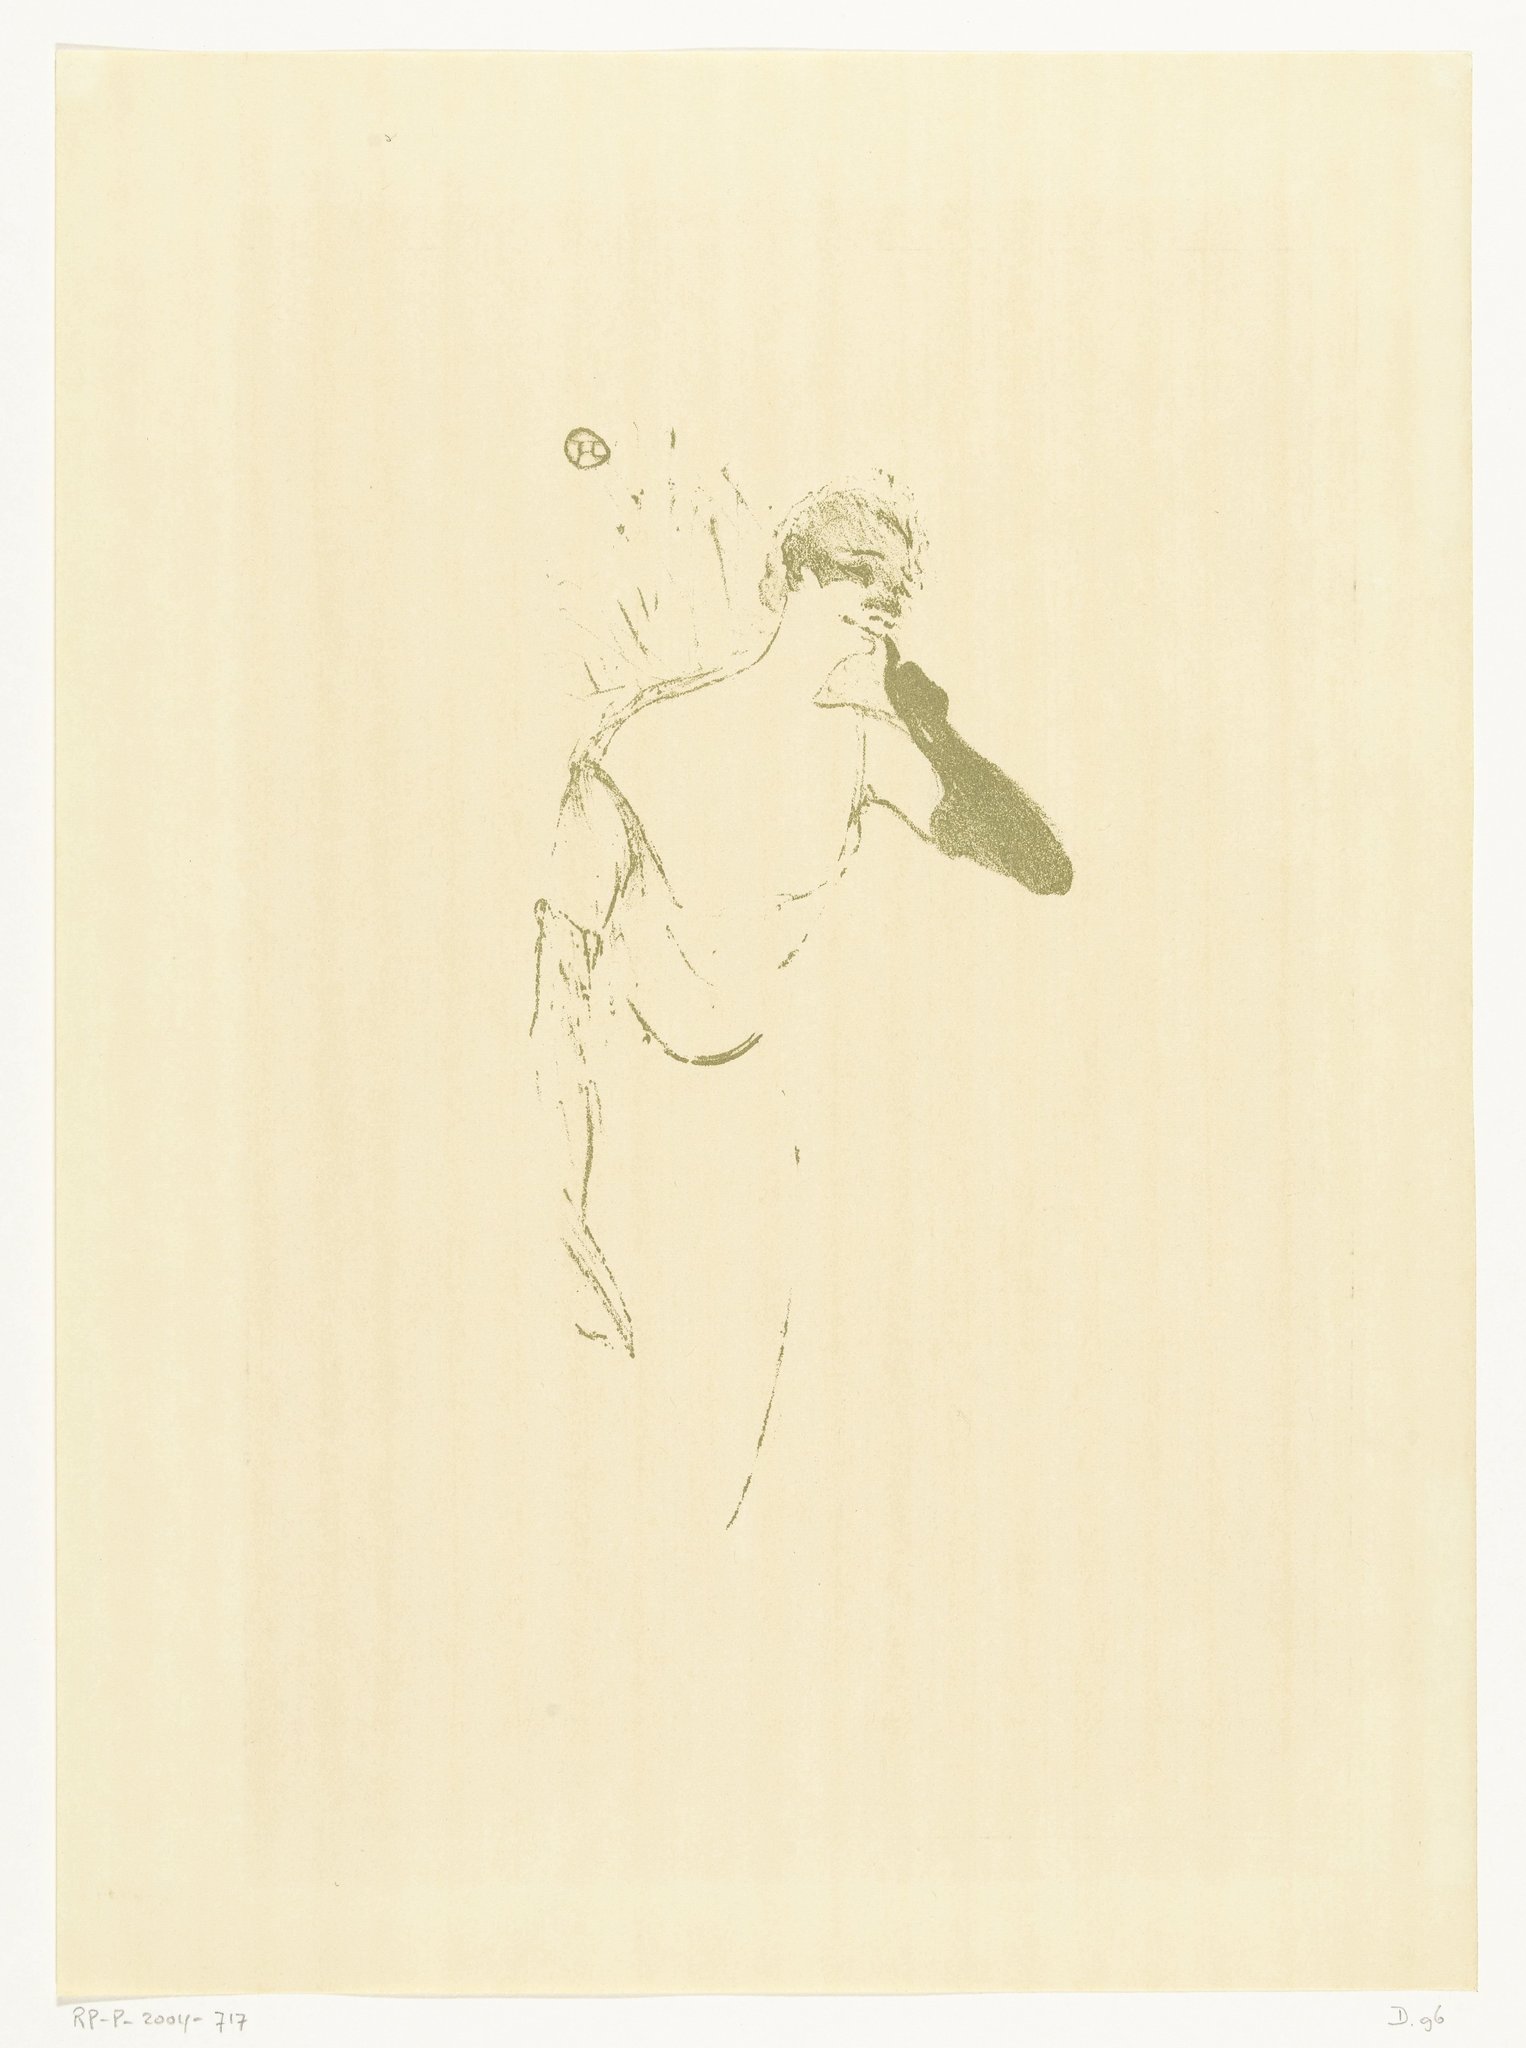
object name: print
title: Yvette Guilbert dans Colombine à Pierrot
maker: henri de toulouse-lautrec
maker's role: draughtsman, painter, print maker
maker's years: 1864-1901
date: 1894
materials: paper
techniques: lithograph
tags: actress (on the stage)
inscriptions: collector's mark: Lugt 2228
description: Het formaat van deze lithografie komt overeen met de drukken in de vierde editie 1950. De kwaliteit van de druk is niet zo goed, sommige lijnen ontbreken of zijn onduidelijk, wat mogelijk wijst op een late druk (vergelijk Wittrock 1985, p. 194 en 196).